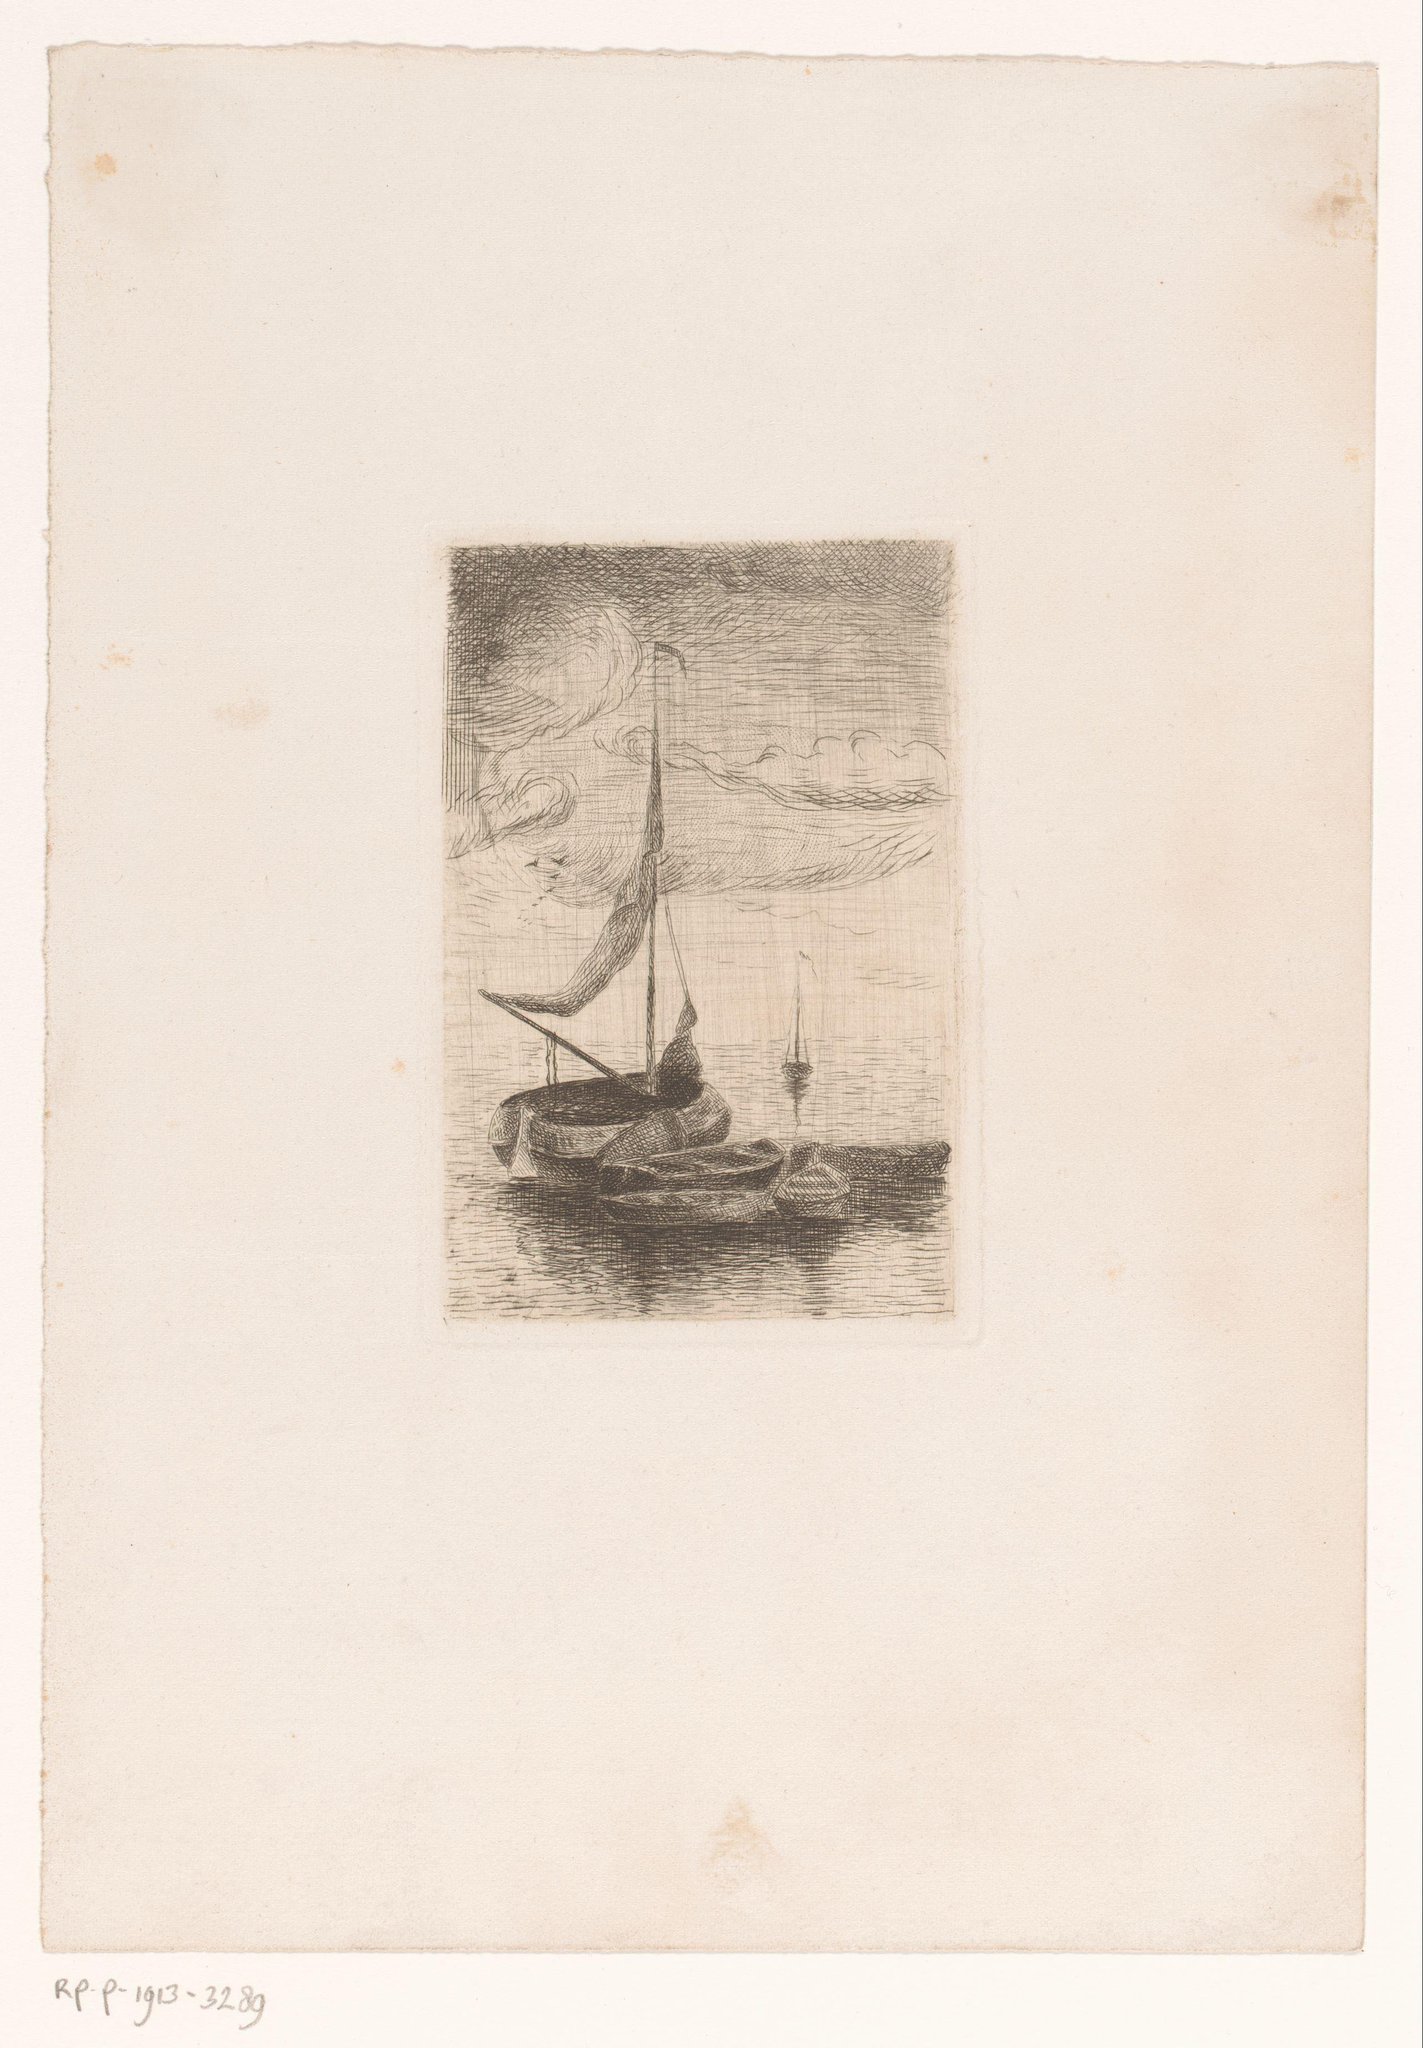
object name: print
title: Boten op het water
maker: frans de vadder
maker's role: print maker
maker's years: 1862-1936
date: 1887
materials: paper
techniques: etching, roulette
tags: sailing-ship, sailing-boat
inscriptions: collector's mark: Lugt 2228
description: Vermoedelijk gaat het om het boottype pink.